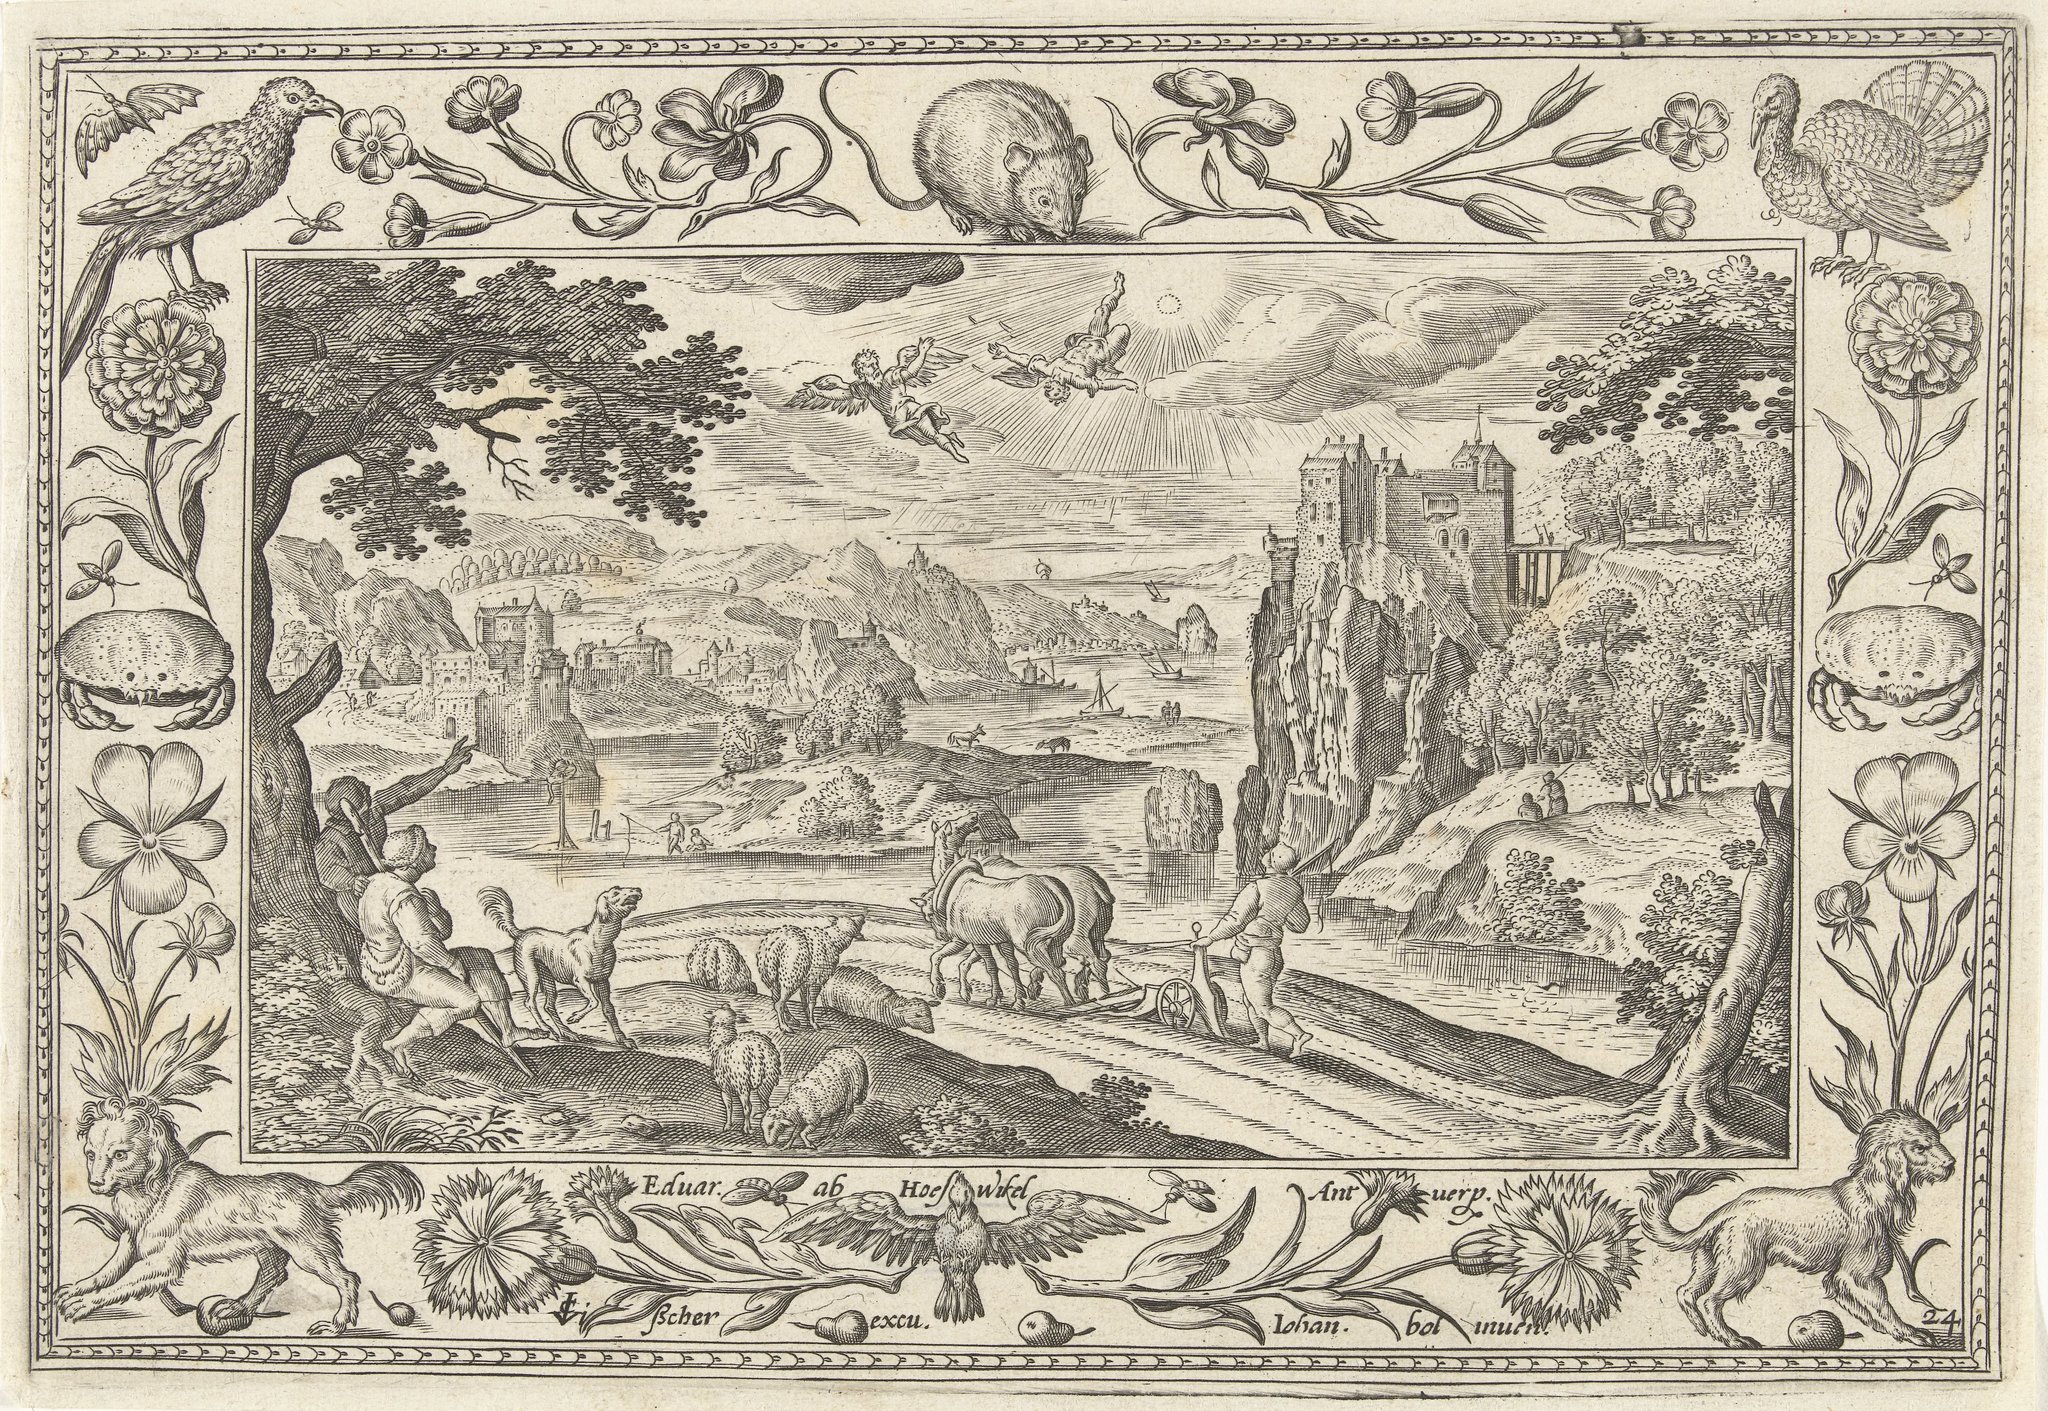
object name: print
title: Landschappen met Bijbelse, mythologische scènes en jachttaferelen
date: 1584-1618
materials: paper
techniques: engraving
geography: antwerp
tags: ornamental birds, death i.e. the fall of icarus (daedalus present), dog (+ ornamental variants of animals), crustaceans: crab (+ ornamental variants of animals), rodents: mouse (+ ornamental variants of animals), cultivated land (+ landscape with figures, staffage), flowers ~ ornament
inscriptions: collector's mark: Lugt 2228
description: Landschap met akker. In de lucht Daedalus en Icarus. Icarus vliegt te hoog bij de zon, de was van zijn vleugels smelt en hij valt uit de lucht. Op de voorgrond kijkt een boer op van het ploegen, terwijl twee herders naar de lucht kijken en wijzen. De prent heeft een ornamentele lijst met bloemen en dieren. Hij maakt deel uit van een vierentwintigdelige serie van landschappen met Bijbelse, mythologische scènes en jachttaferelen.